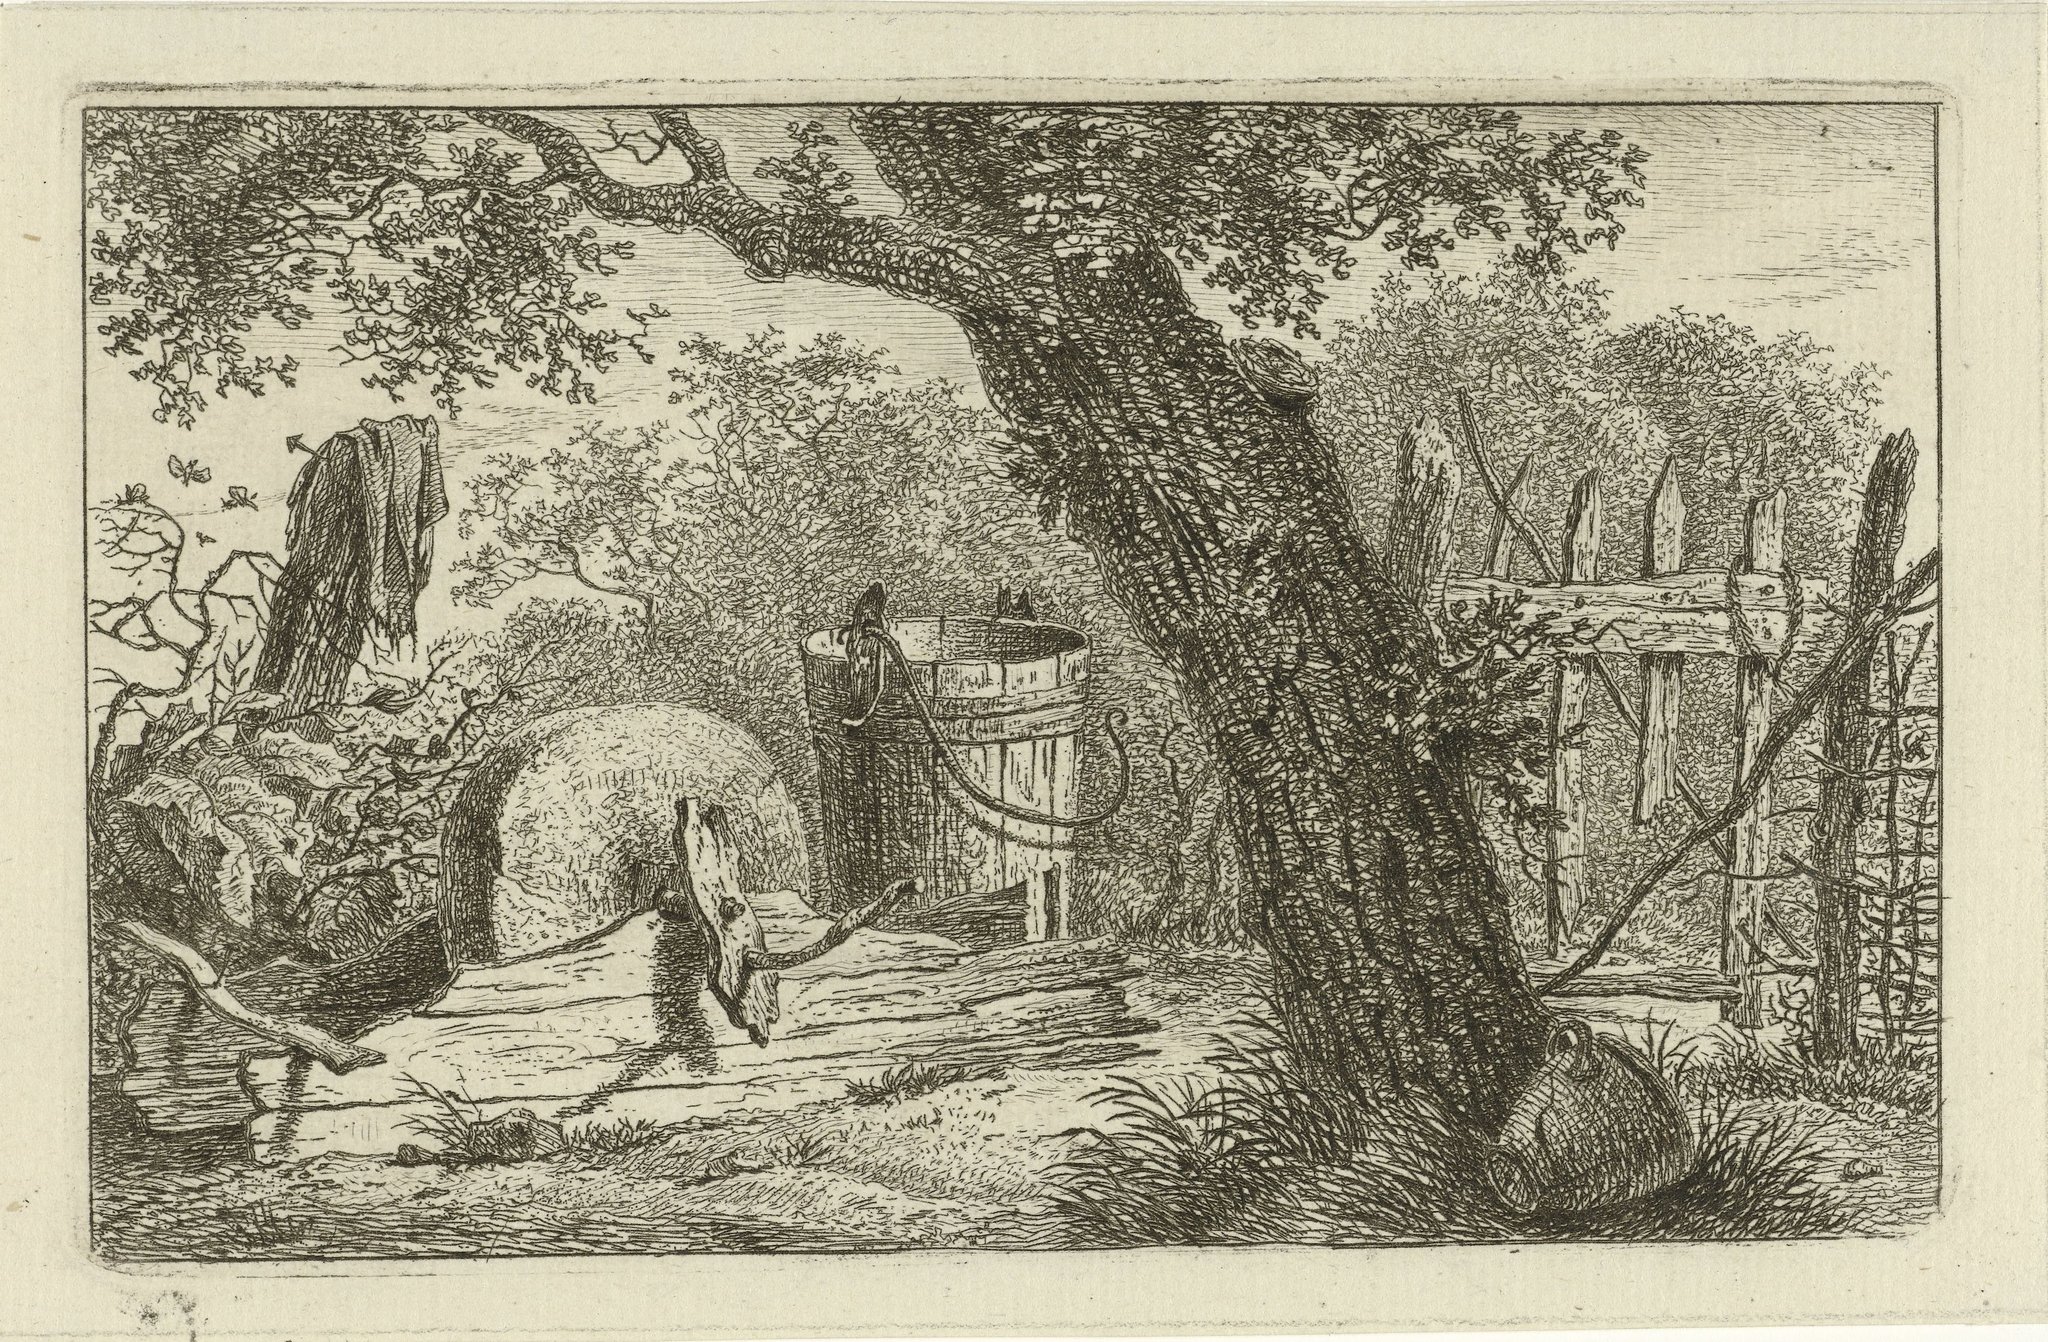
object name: print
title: Landschap met slijpsteen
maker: hermanus fock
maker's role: conservator, draughtsman, painter, print maker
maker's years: 1766-1822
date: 1781-1822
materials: paper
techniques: etching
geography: amsterdam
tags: tools, aids, implements ~ crafts and industries: grindstone (+ outdoors; in the open air)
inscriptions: collector's mark: Lugt 2228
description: Een gezicht op een slijpsteen en een houten emmer onder een boom. Op de achtergrond een hek.